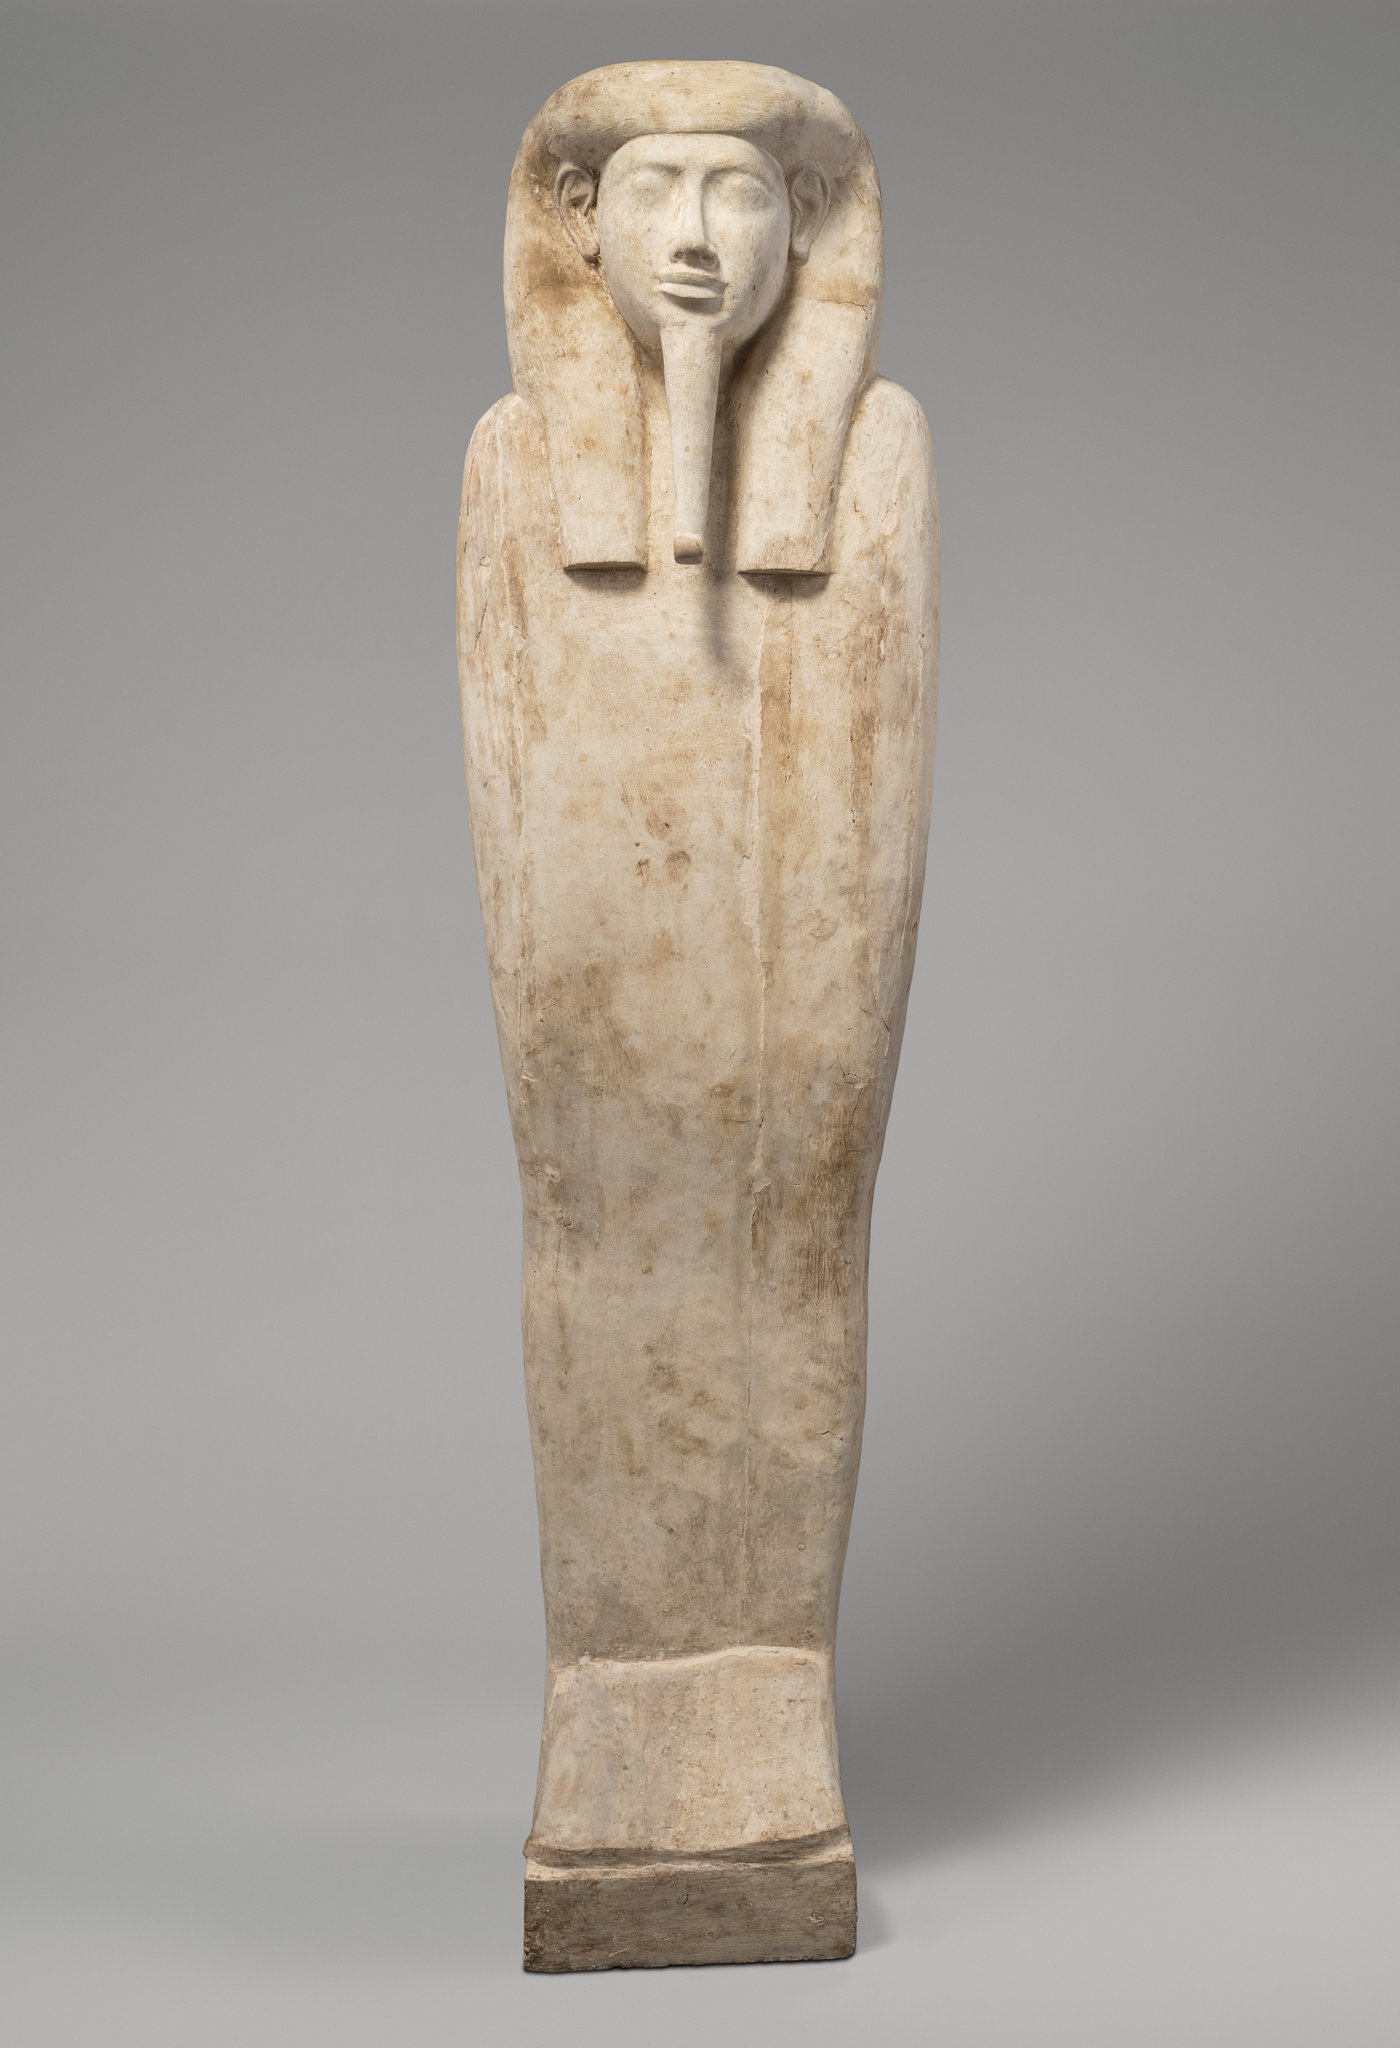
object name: coffin, undecorated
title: Undecorated Coffin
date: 650-625 BCE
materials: paste, wood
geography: egypt